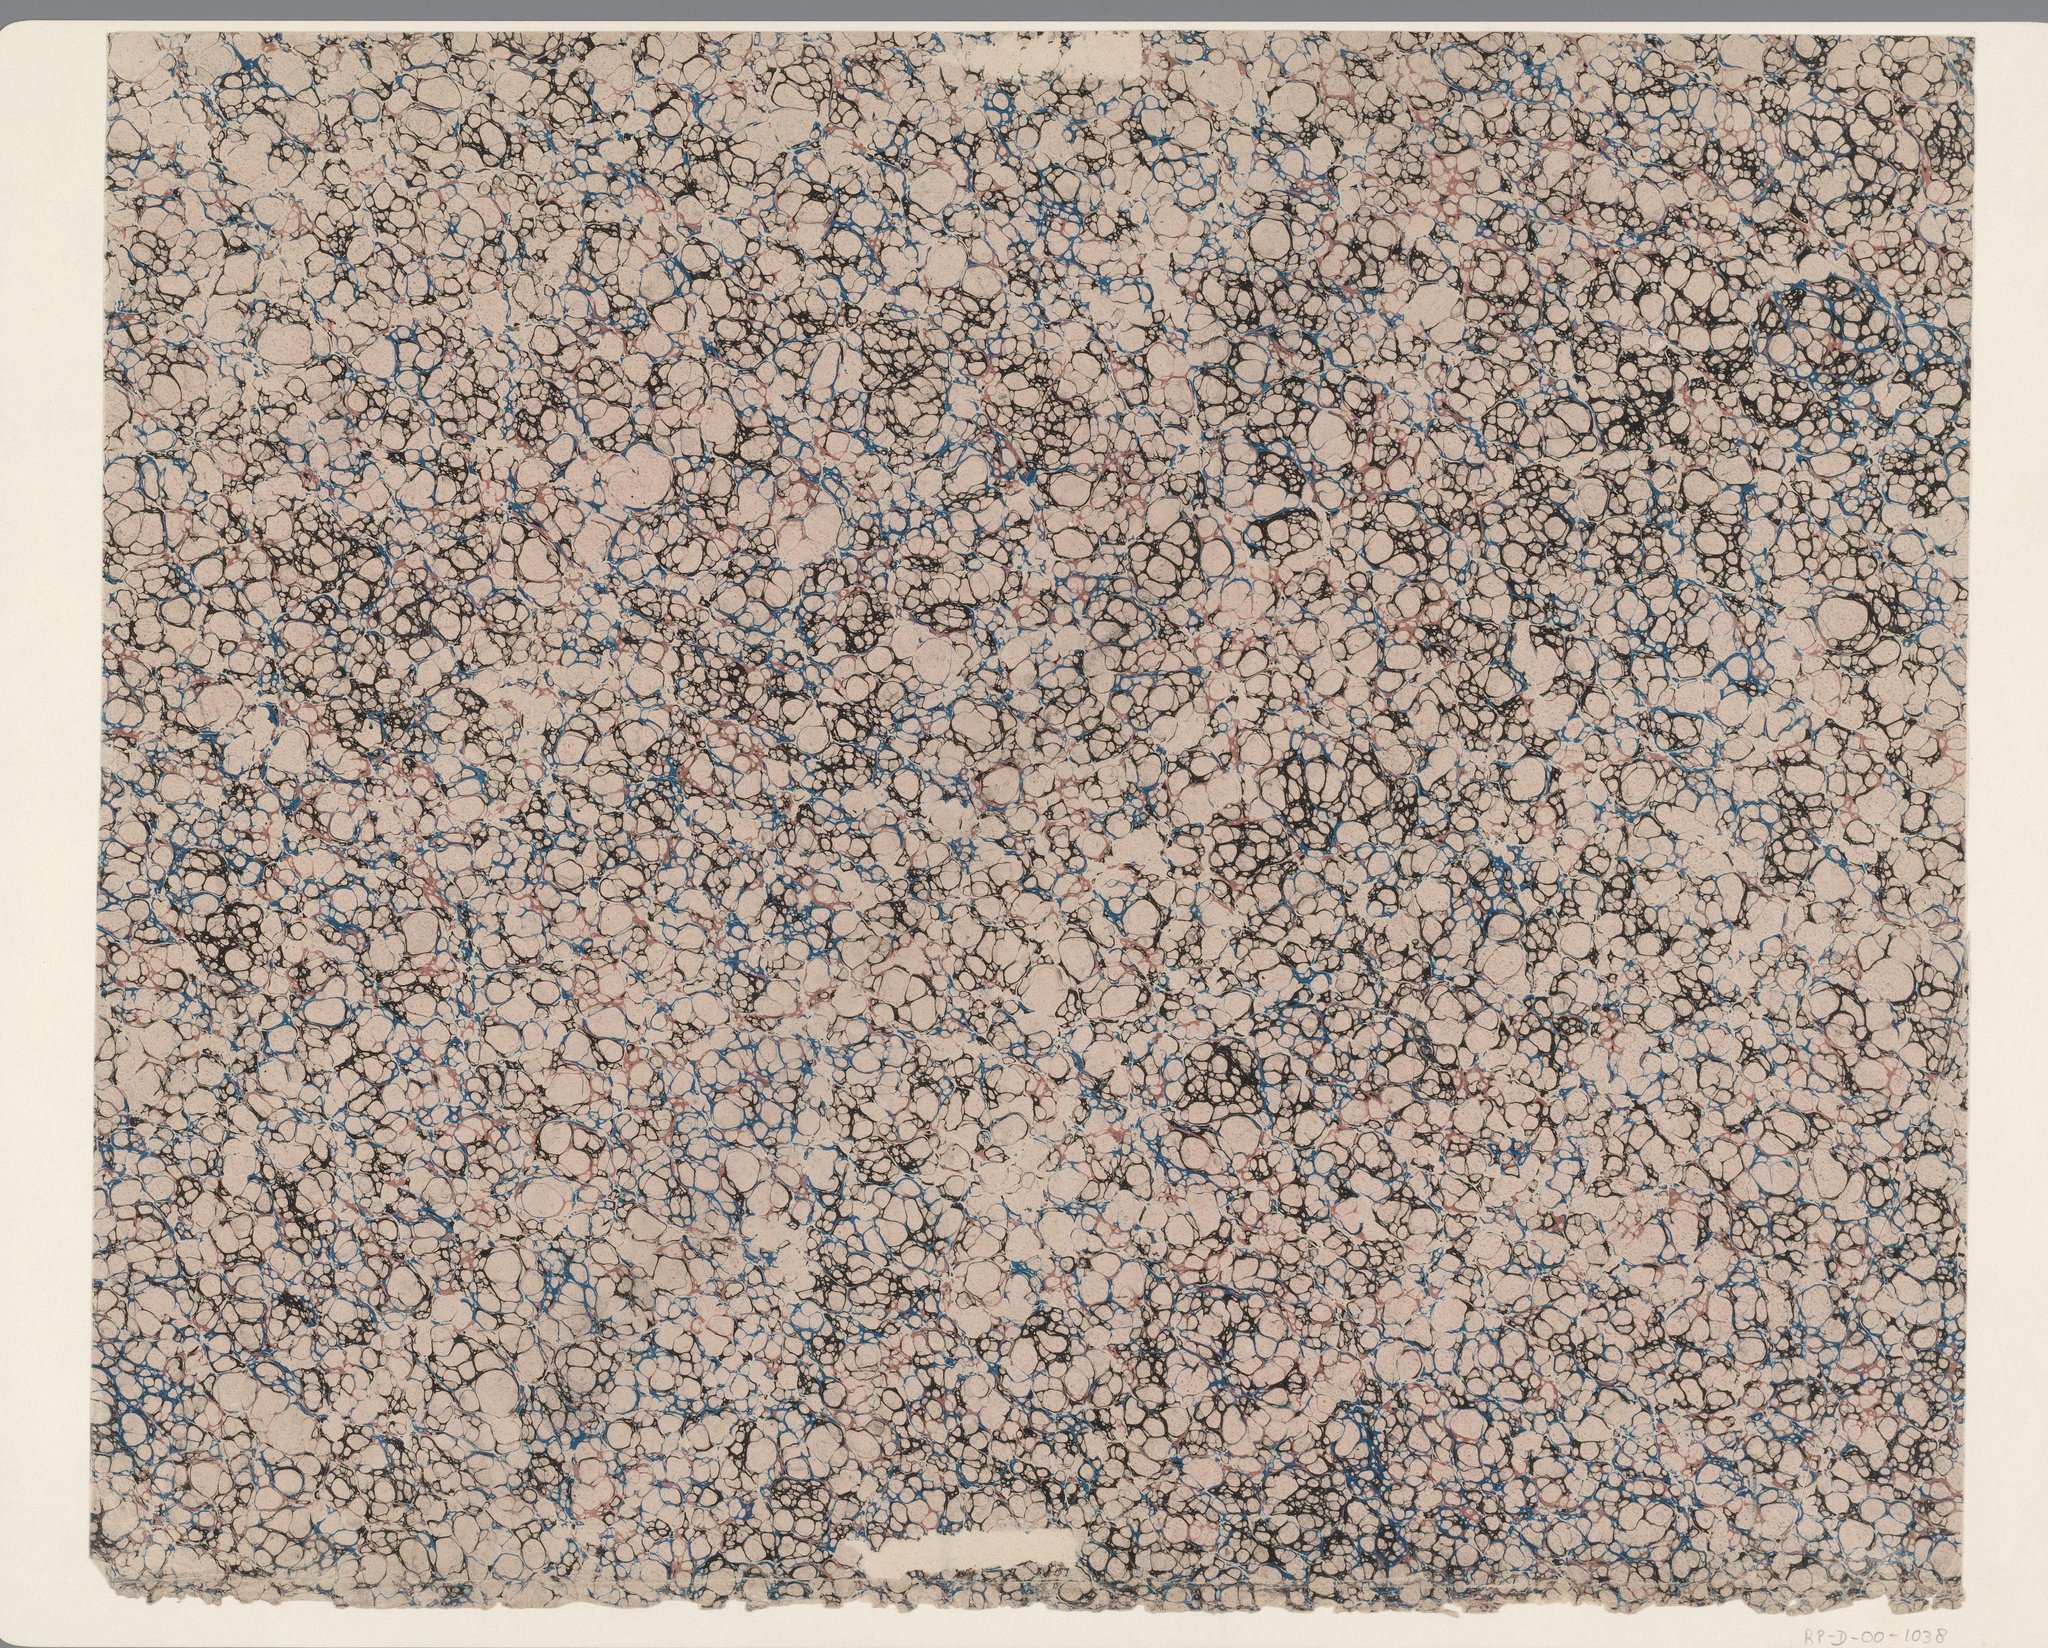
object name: marbled paper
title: Adermarmer in roze, zwart, rood en blauw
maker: Anonymous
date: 1700-1850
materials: paint, paper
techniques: marbling